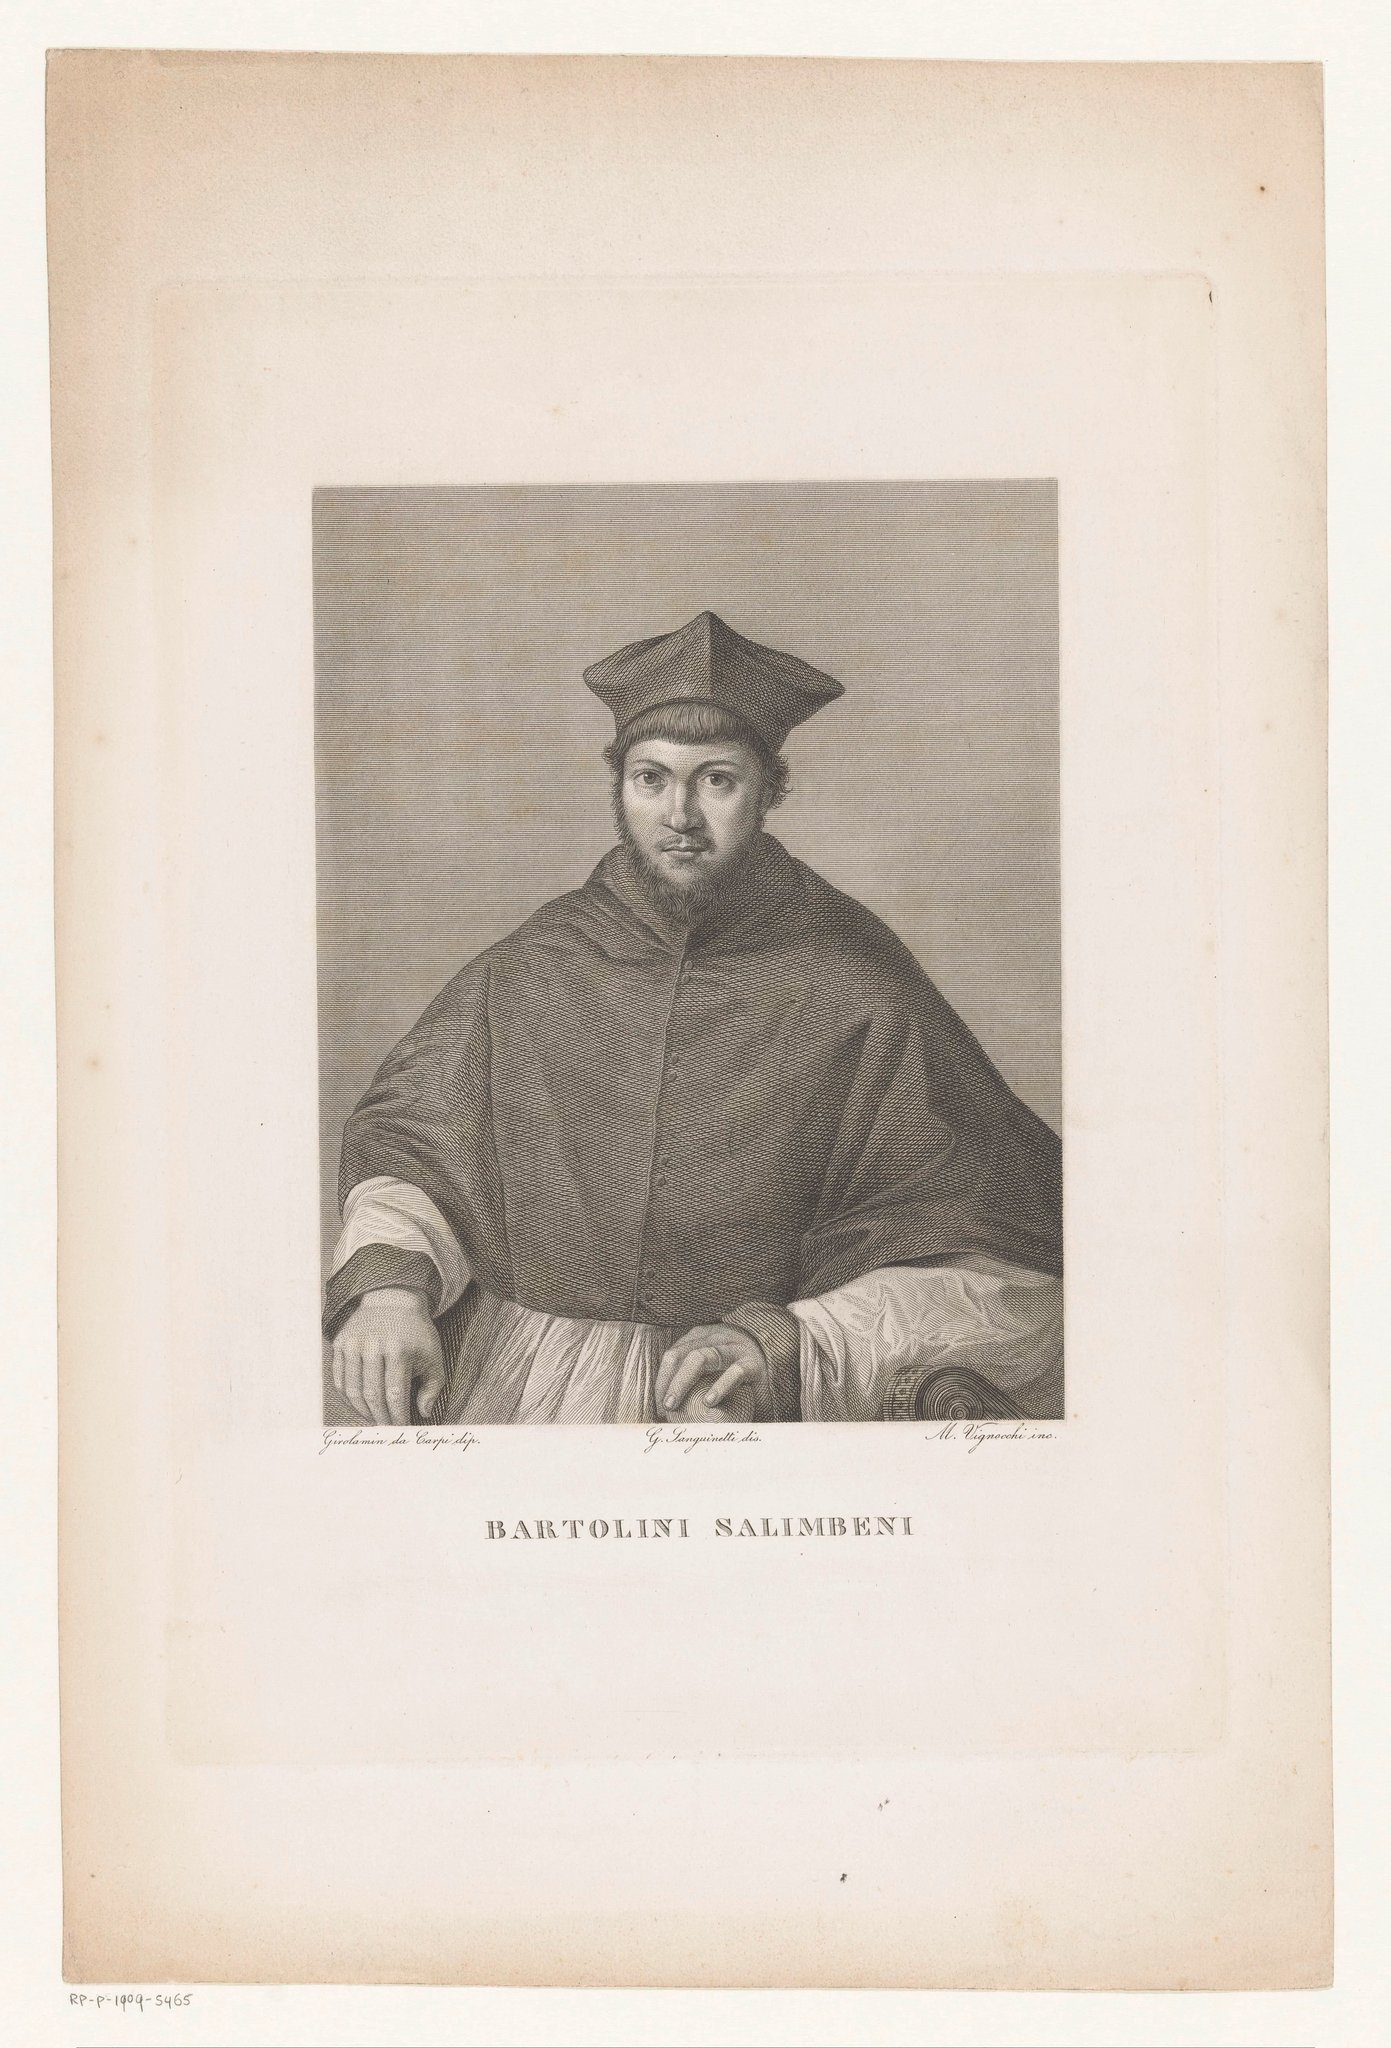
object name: print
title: Portret van aartsbisschop Onofrio Bartolini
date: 1800-1899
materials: paper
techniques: engraving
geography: italy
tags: archbishop, bishop, etc. (roman catholic), historical persons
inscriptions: collector's mark: Lugt 2228